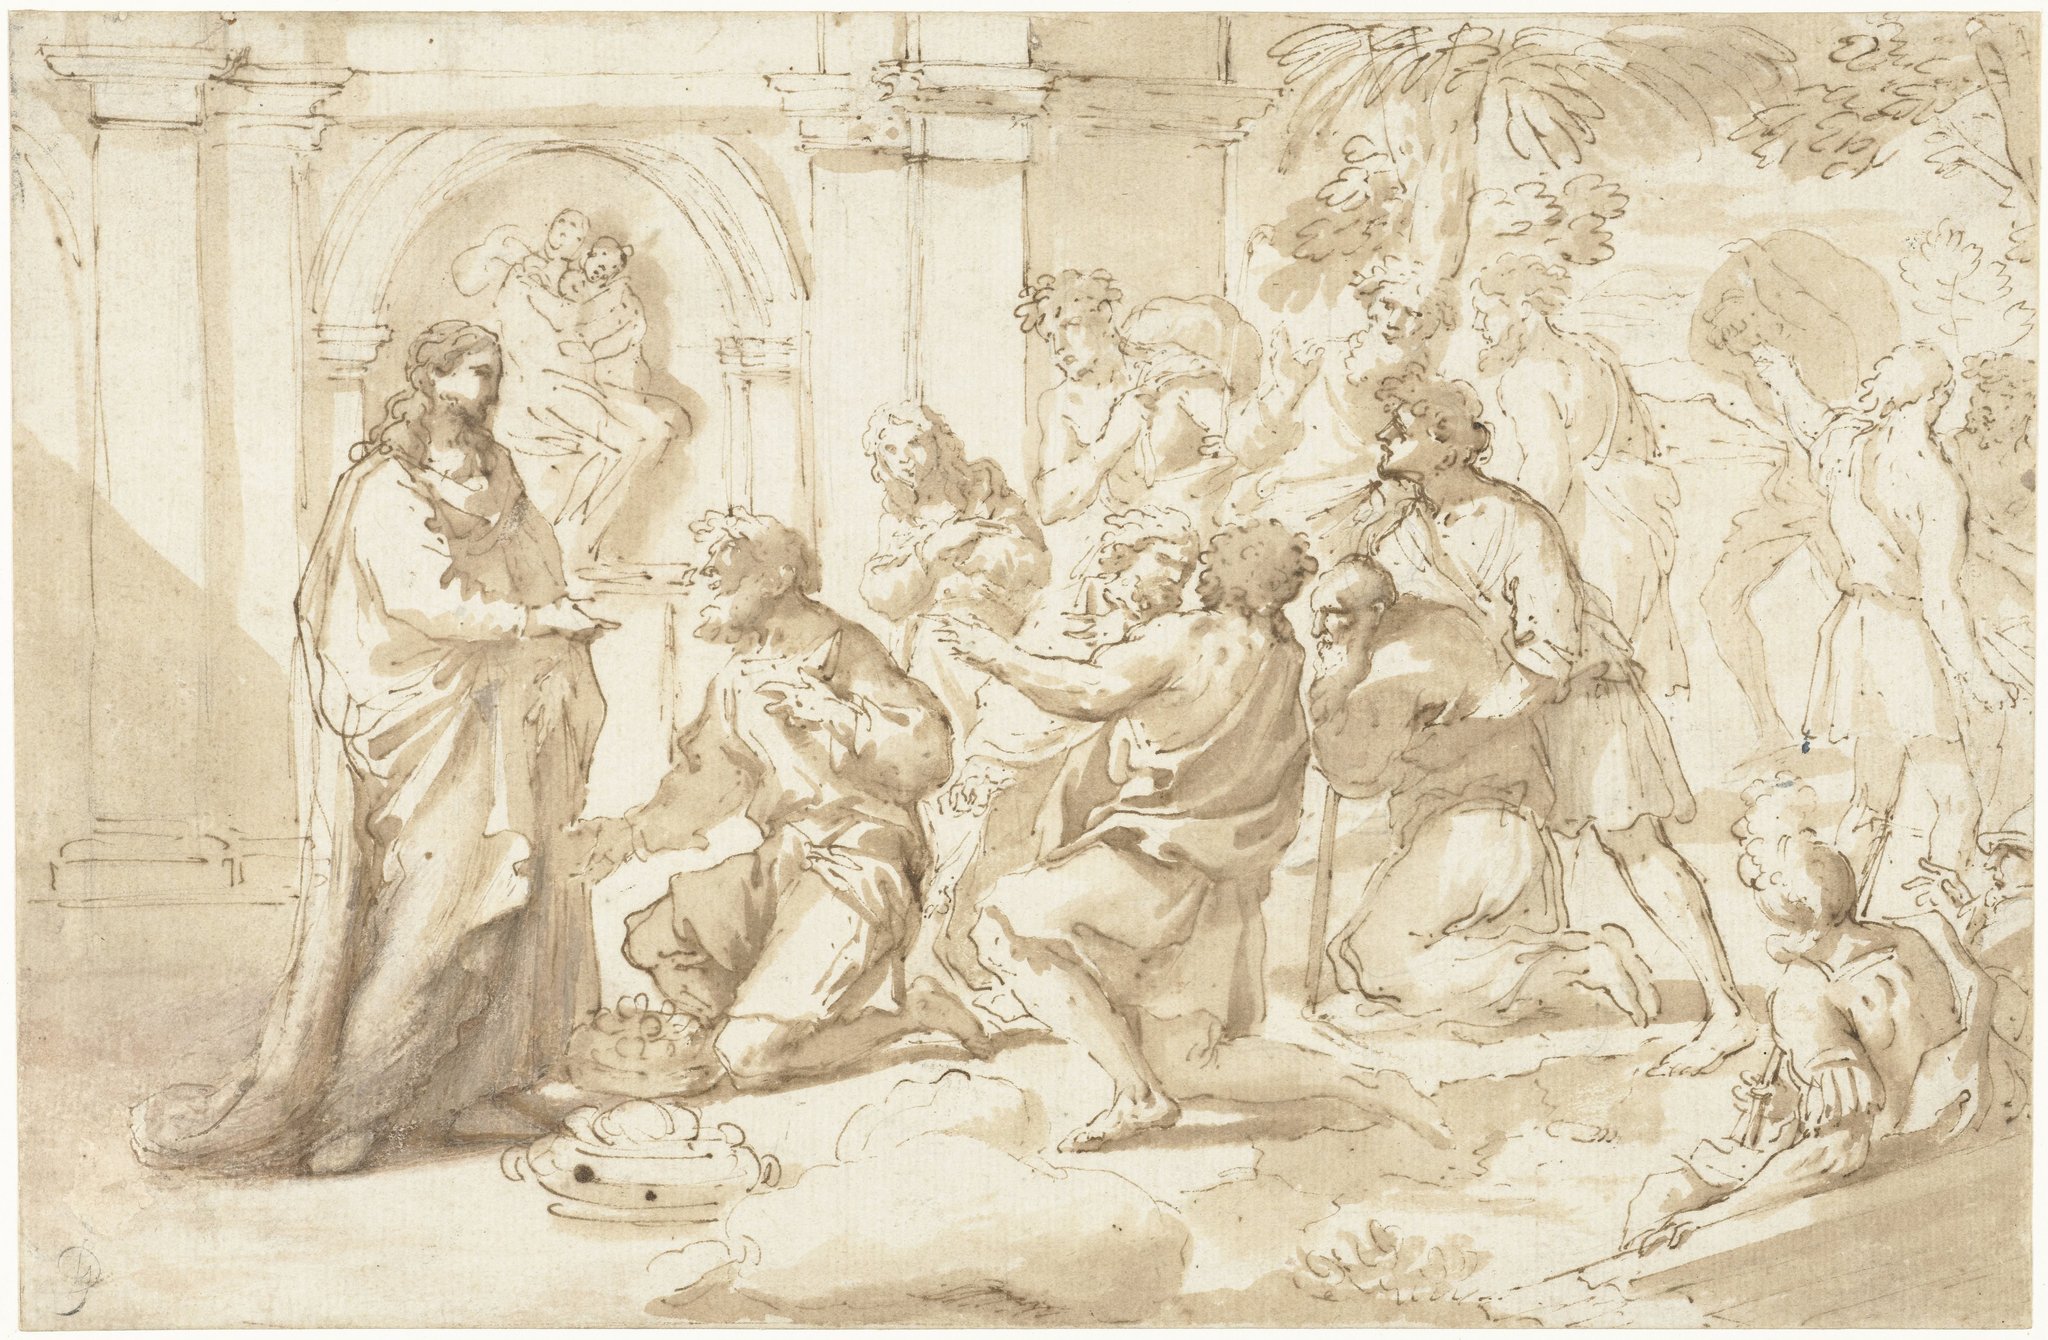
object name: drawing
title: Jozef door zijn broeders herkend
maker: guglielmo cortese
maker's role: draughtsman, painter, print maker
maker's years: 1628-1679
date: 1652-1662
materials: chalk, ink, paint, paper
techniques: brush, pen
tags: admitted in joseph's presence, the brothers bow down before him